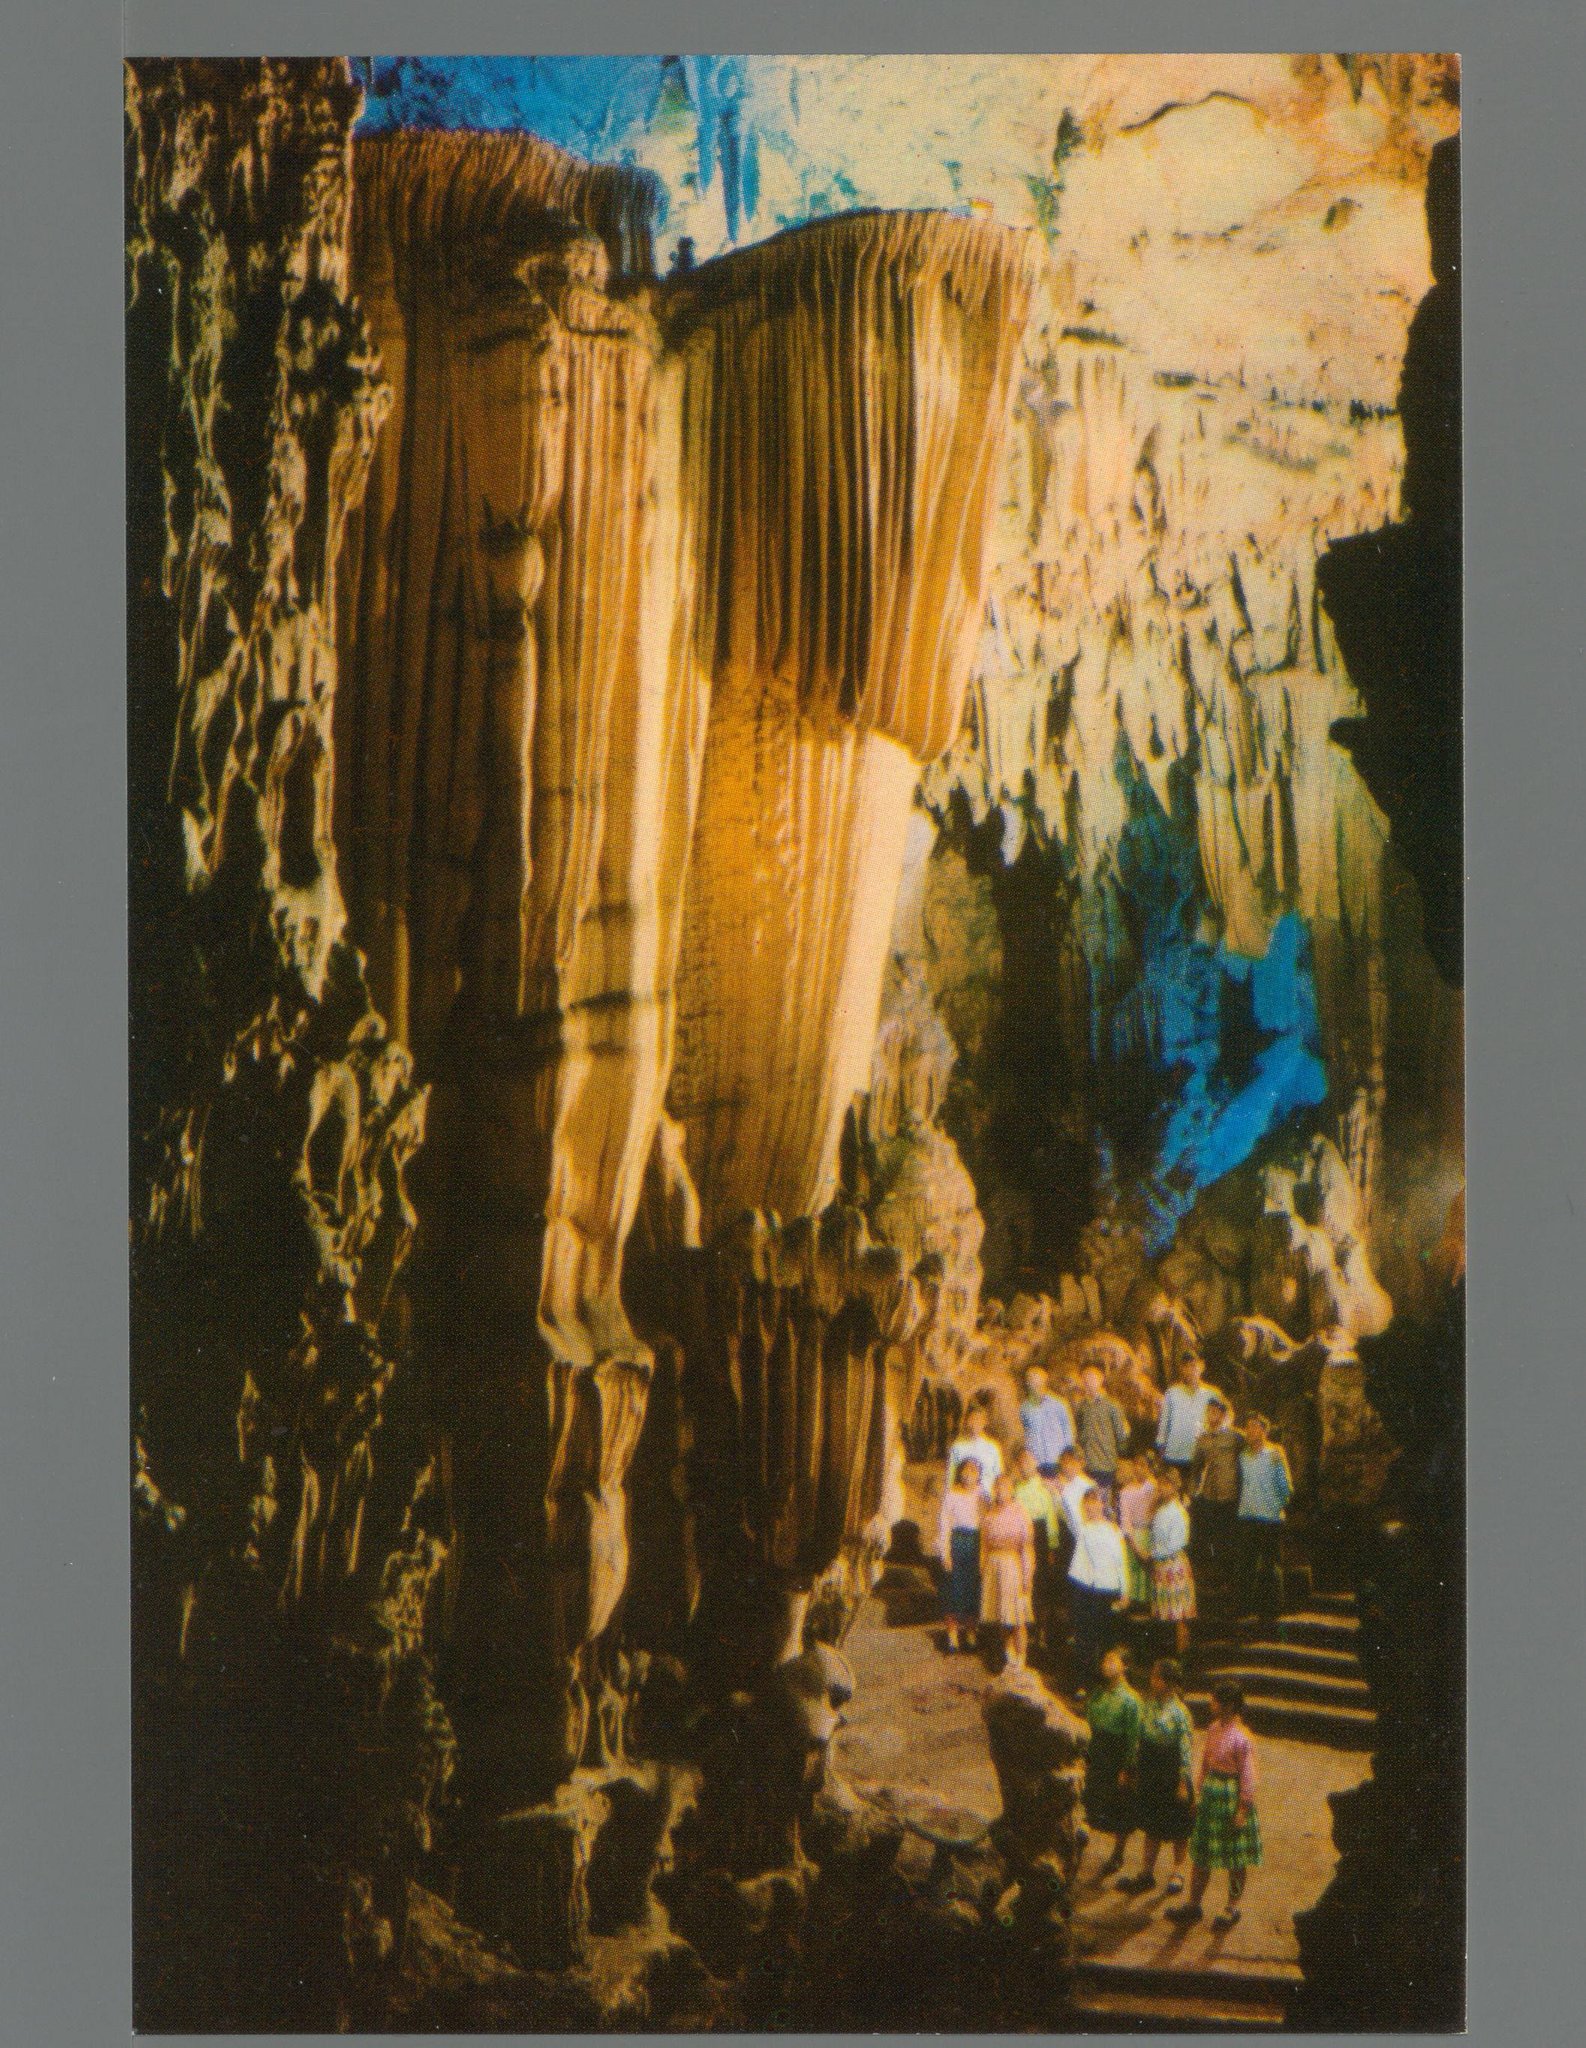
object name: photomechanical print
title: Dripstones in Reed Flute Cavern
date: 1974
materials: cardboard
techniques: offset printed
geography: guilin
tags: stalactitic cave